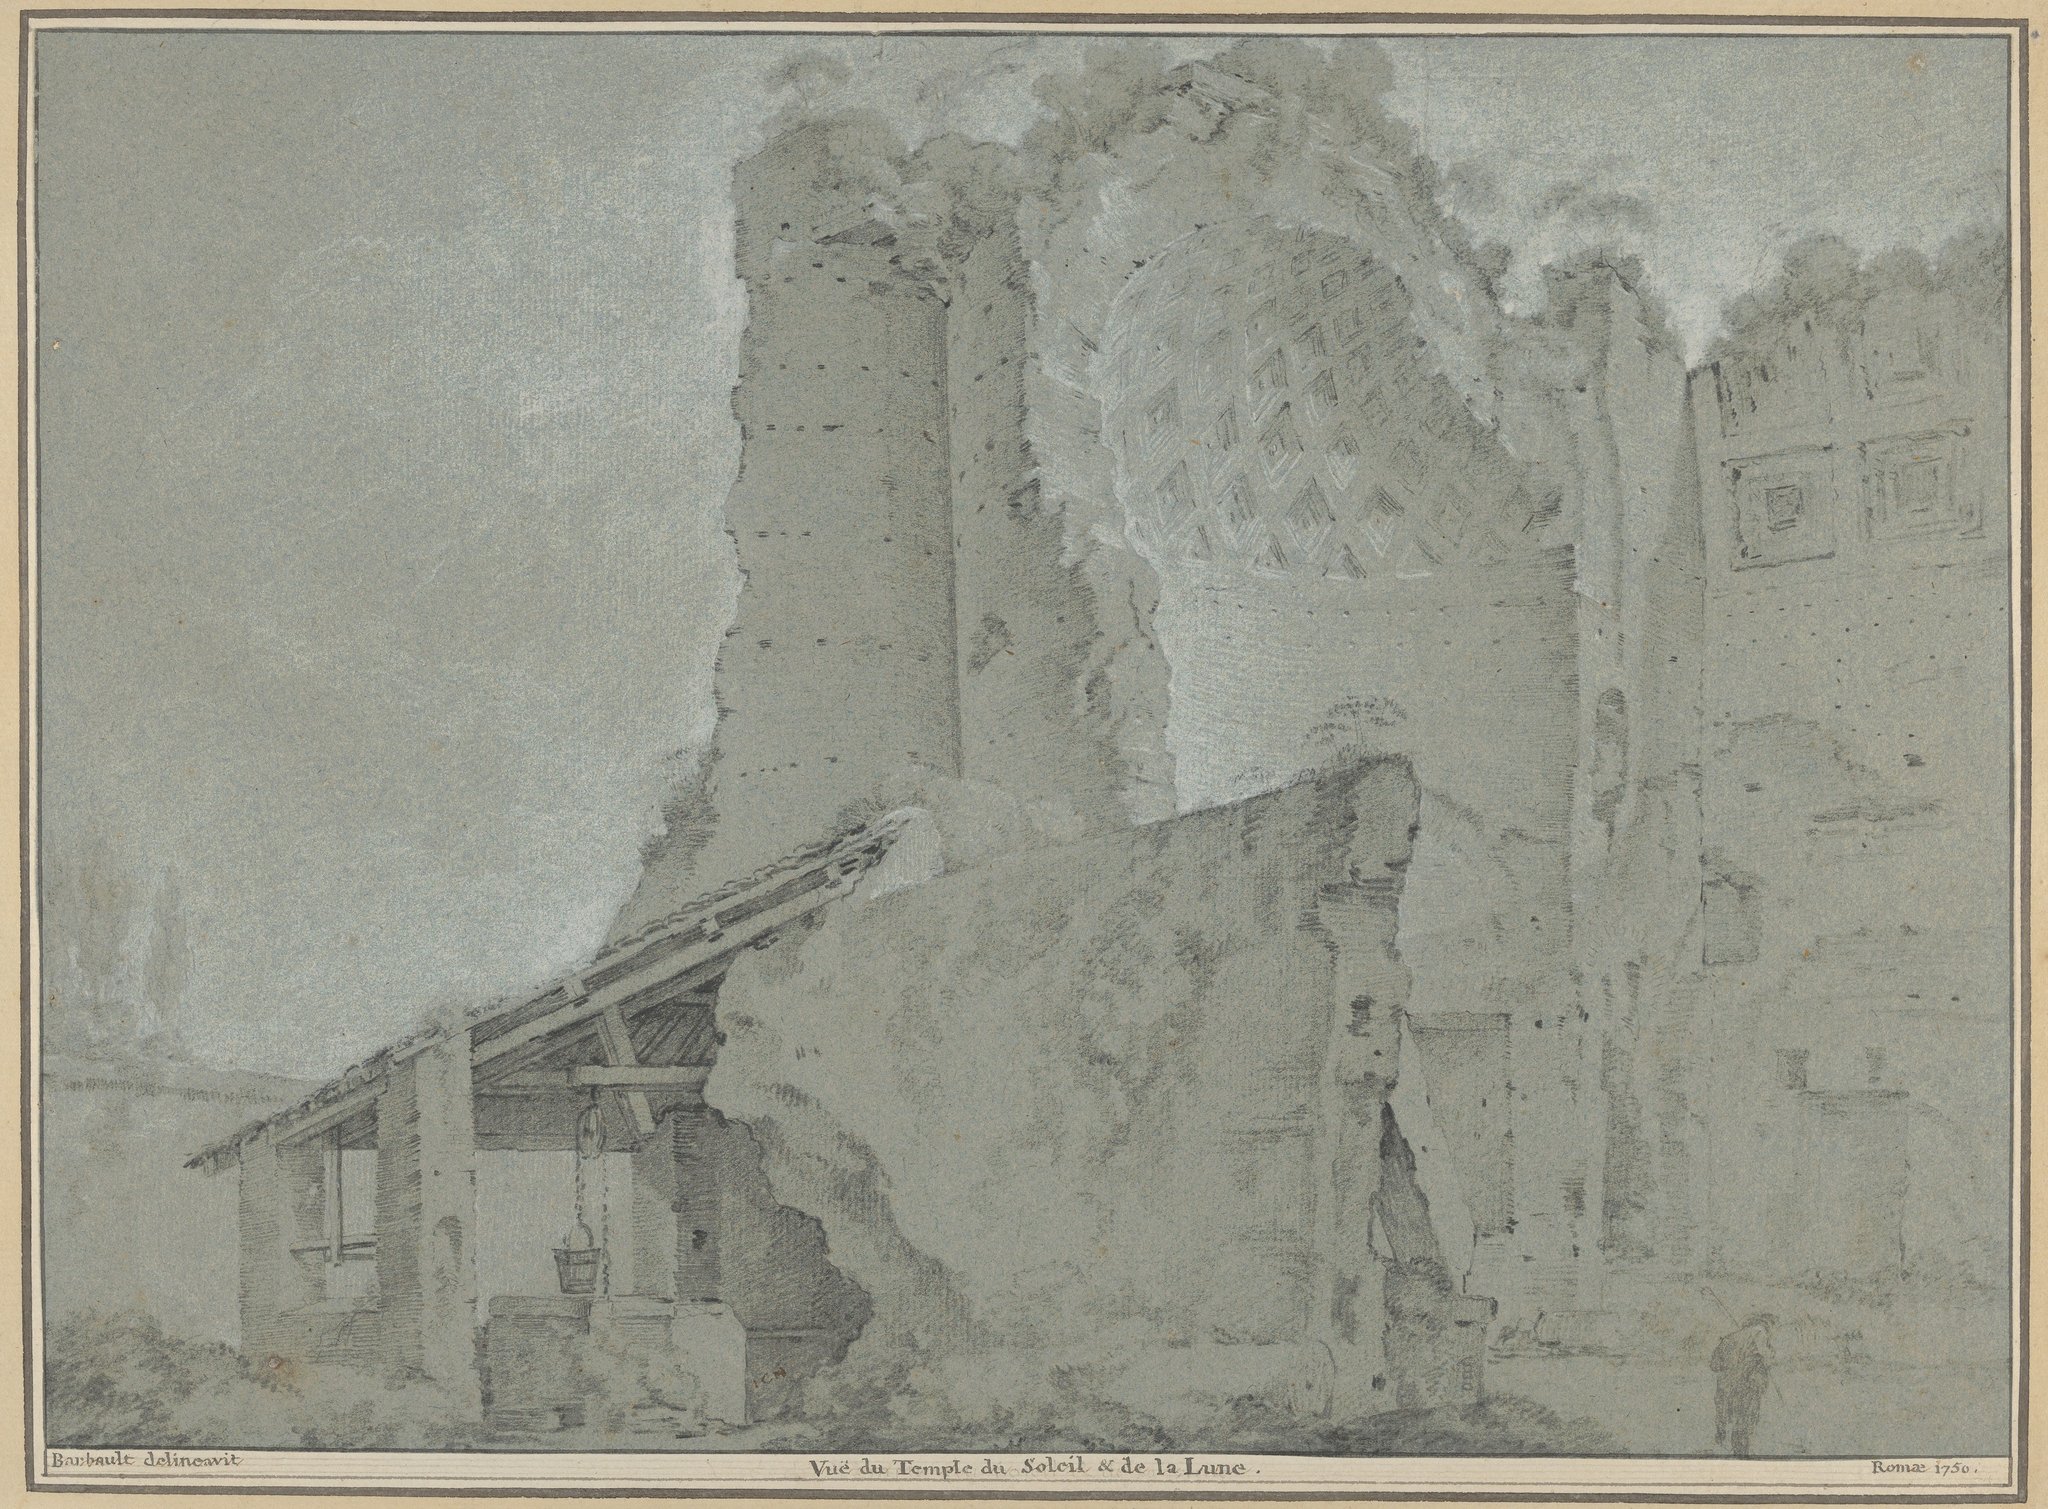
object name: drawing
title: Temple of the Sun and the Moon in Rome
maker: jean barbault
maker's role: artist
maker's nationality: french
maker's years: 1718-1762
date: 1750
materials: chalk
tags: temples,ruins